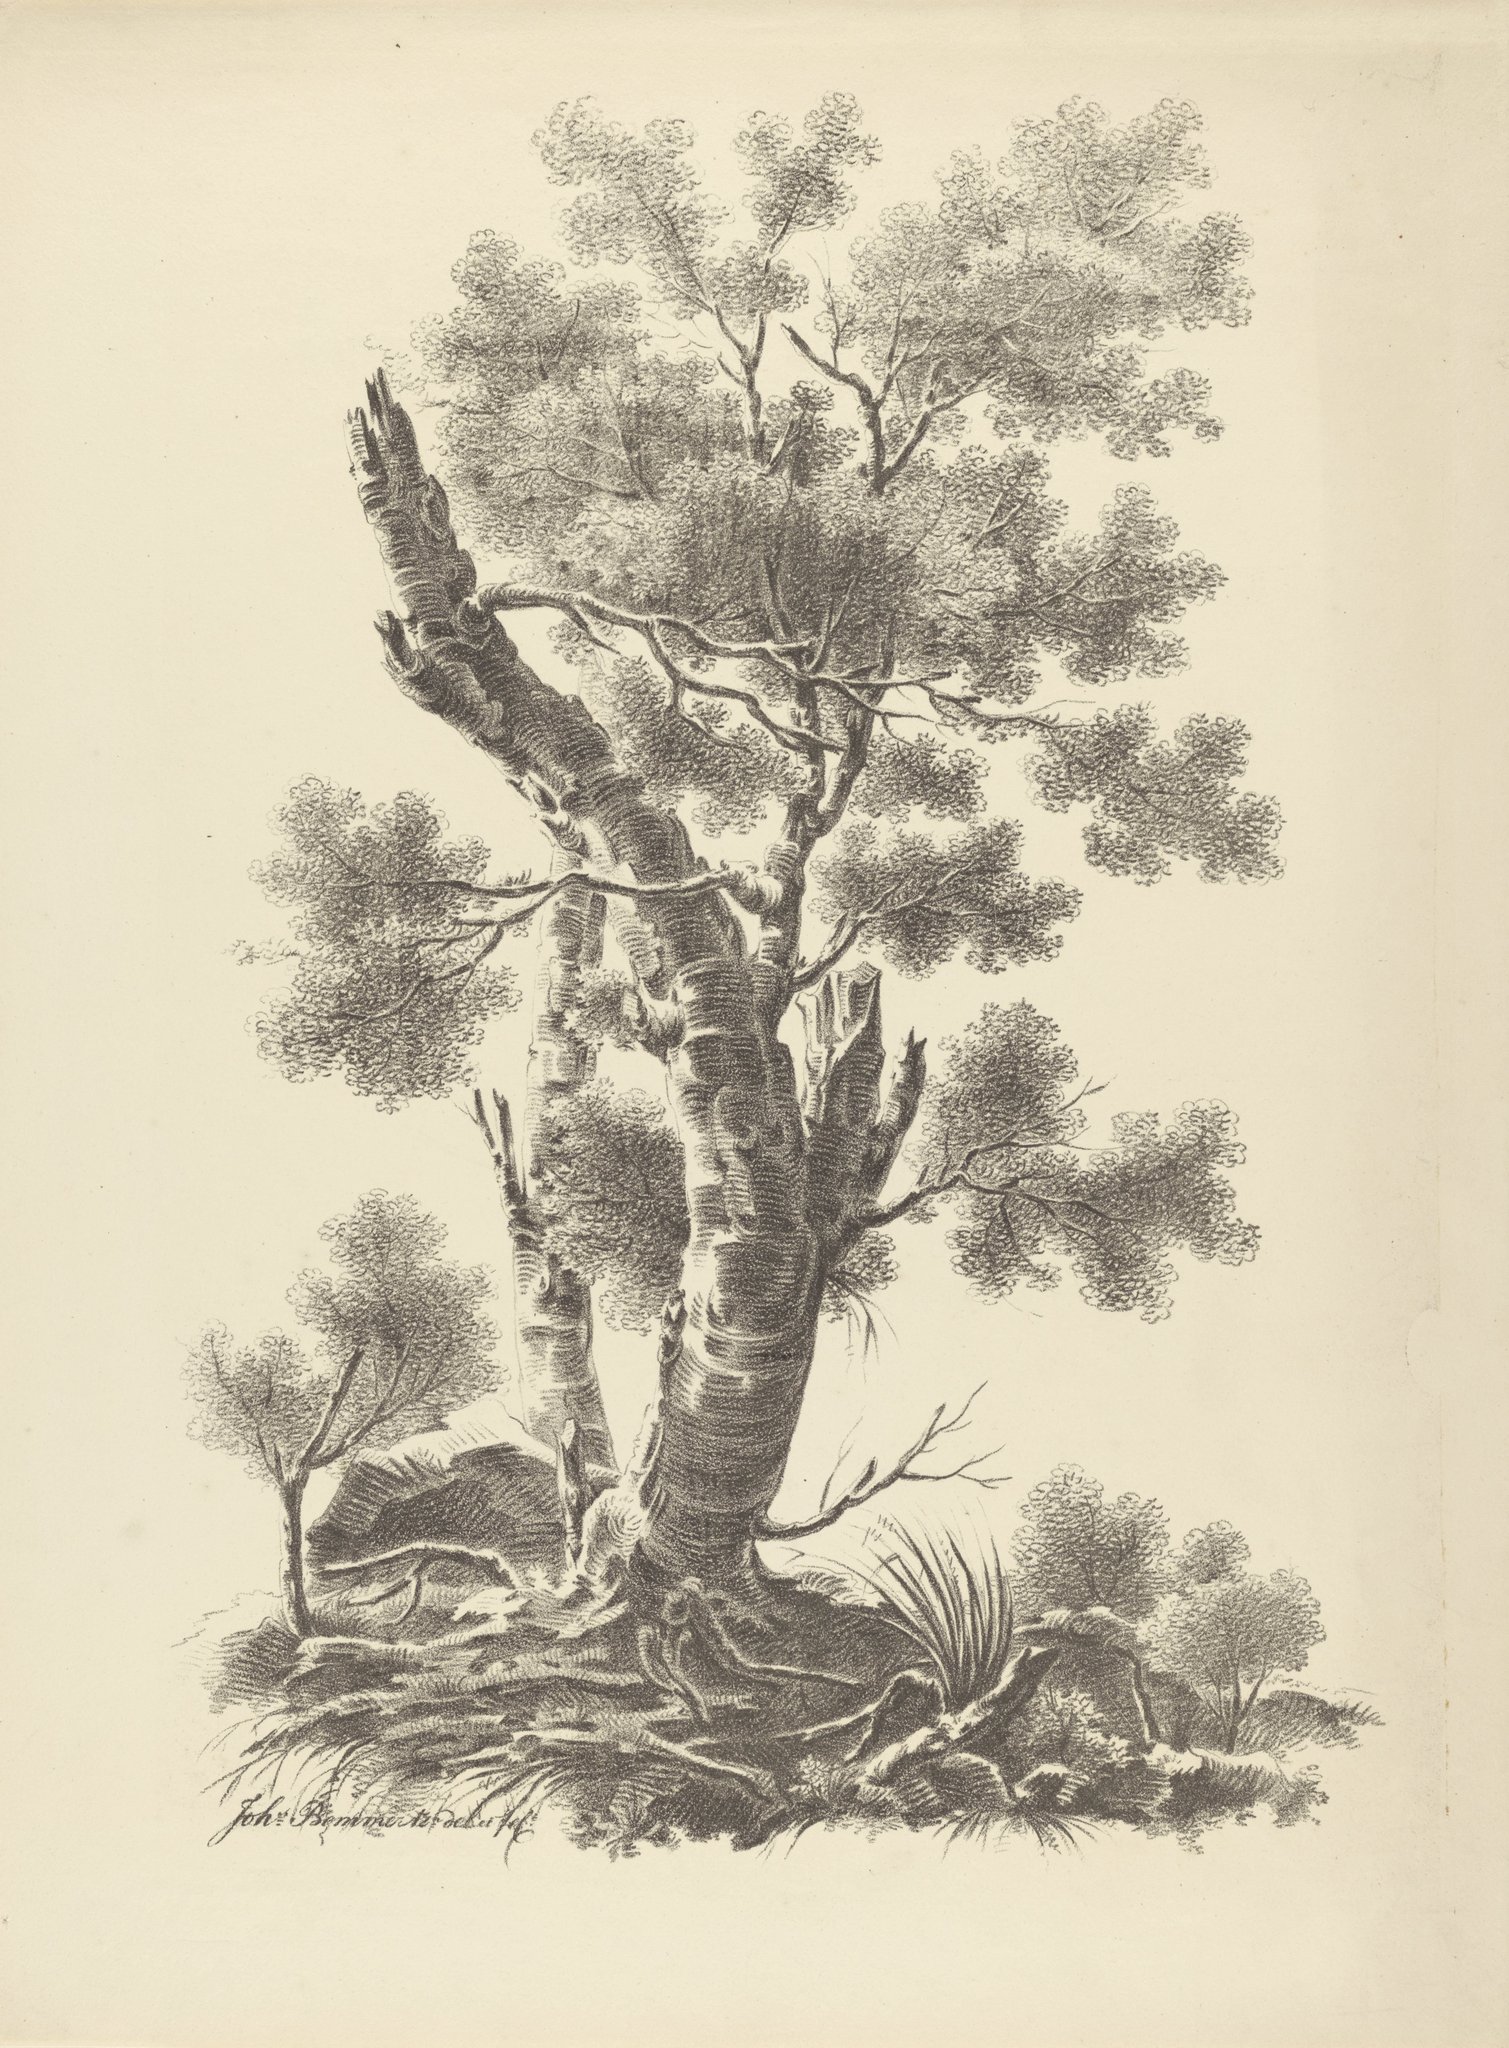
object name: print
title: Afgebroken boom met bladeren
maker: joannes bemme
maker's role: print maker, printer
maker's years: 1775-1841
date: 1809-1841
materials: paper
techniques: lithograph, lithography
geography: netherlands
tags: trees, rocks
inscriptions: collector's mark: Lugt 2228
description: De dikke stam maakt een buiging naar links en is bovenin afgebroken. Links en rechts takken die blad dragen. Op de grond verschillende gewassen en een steen.